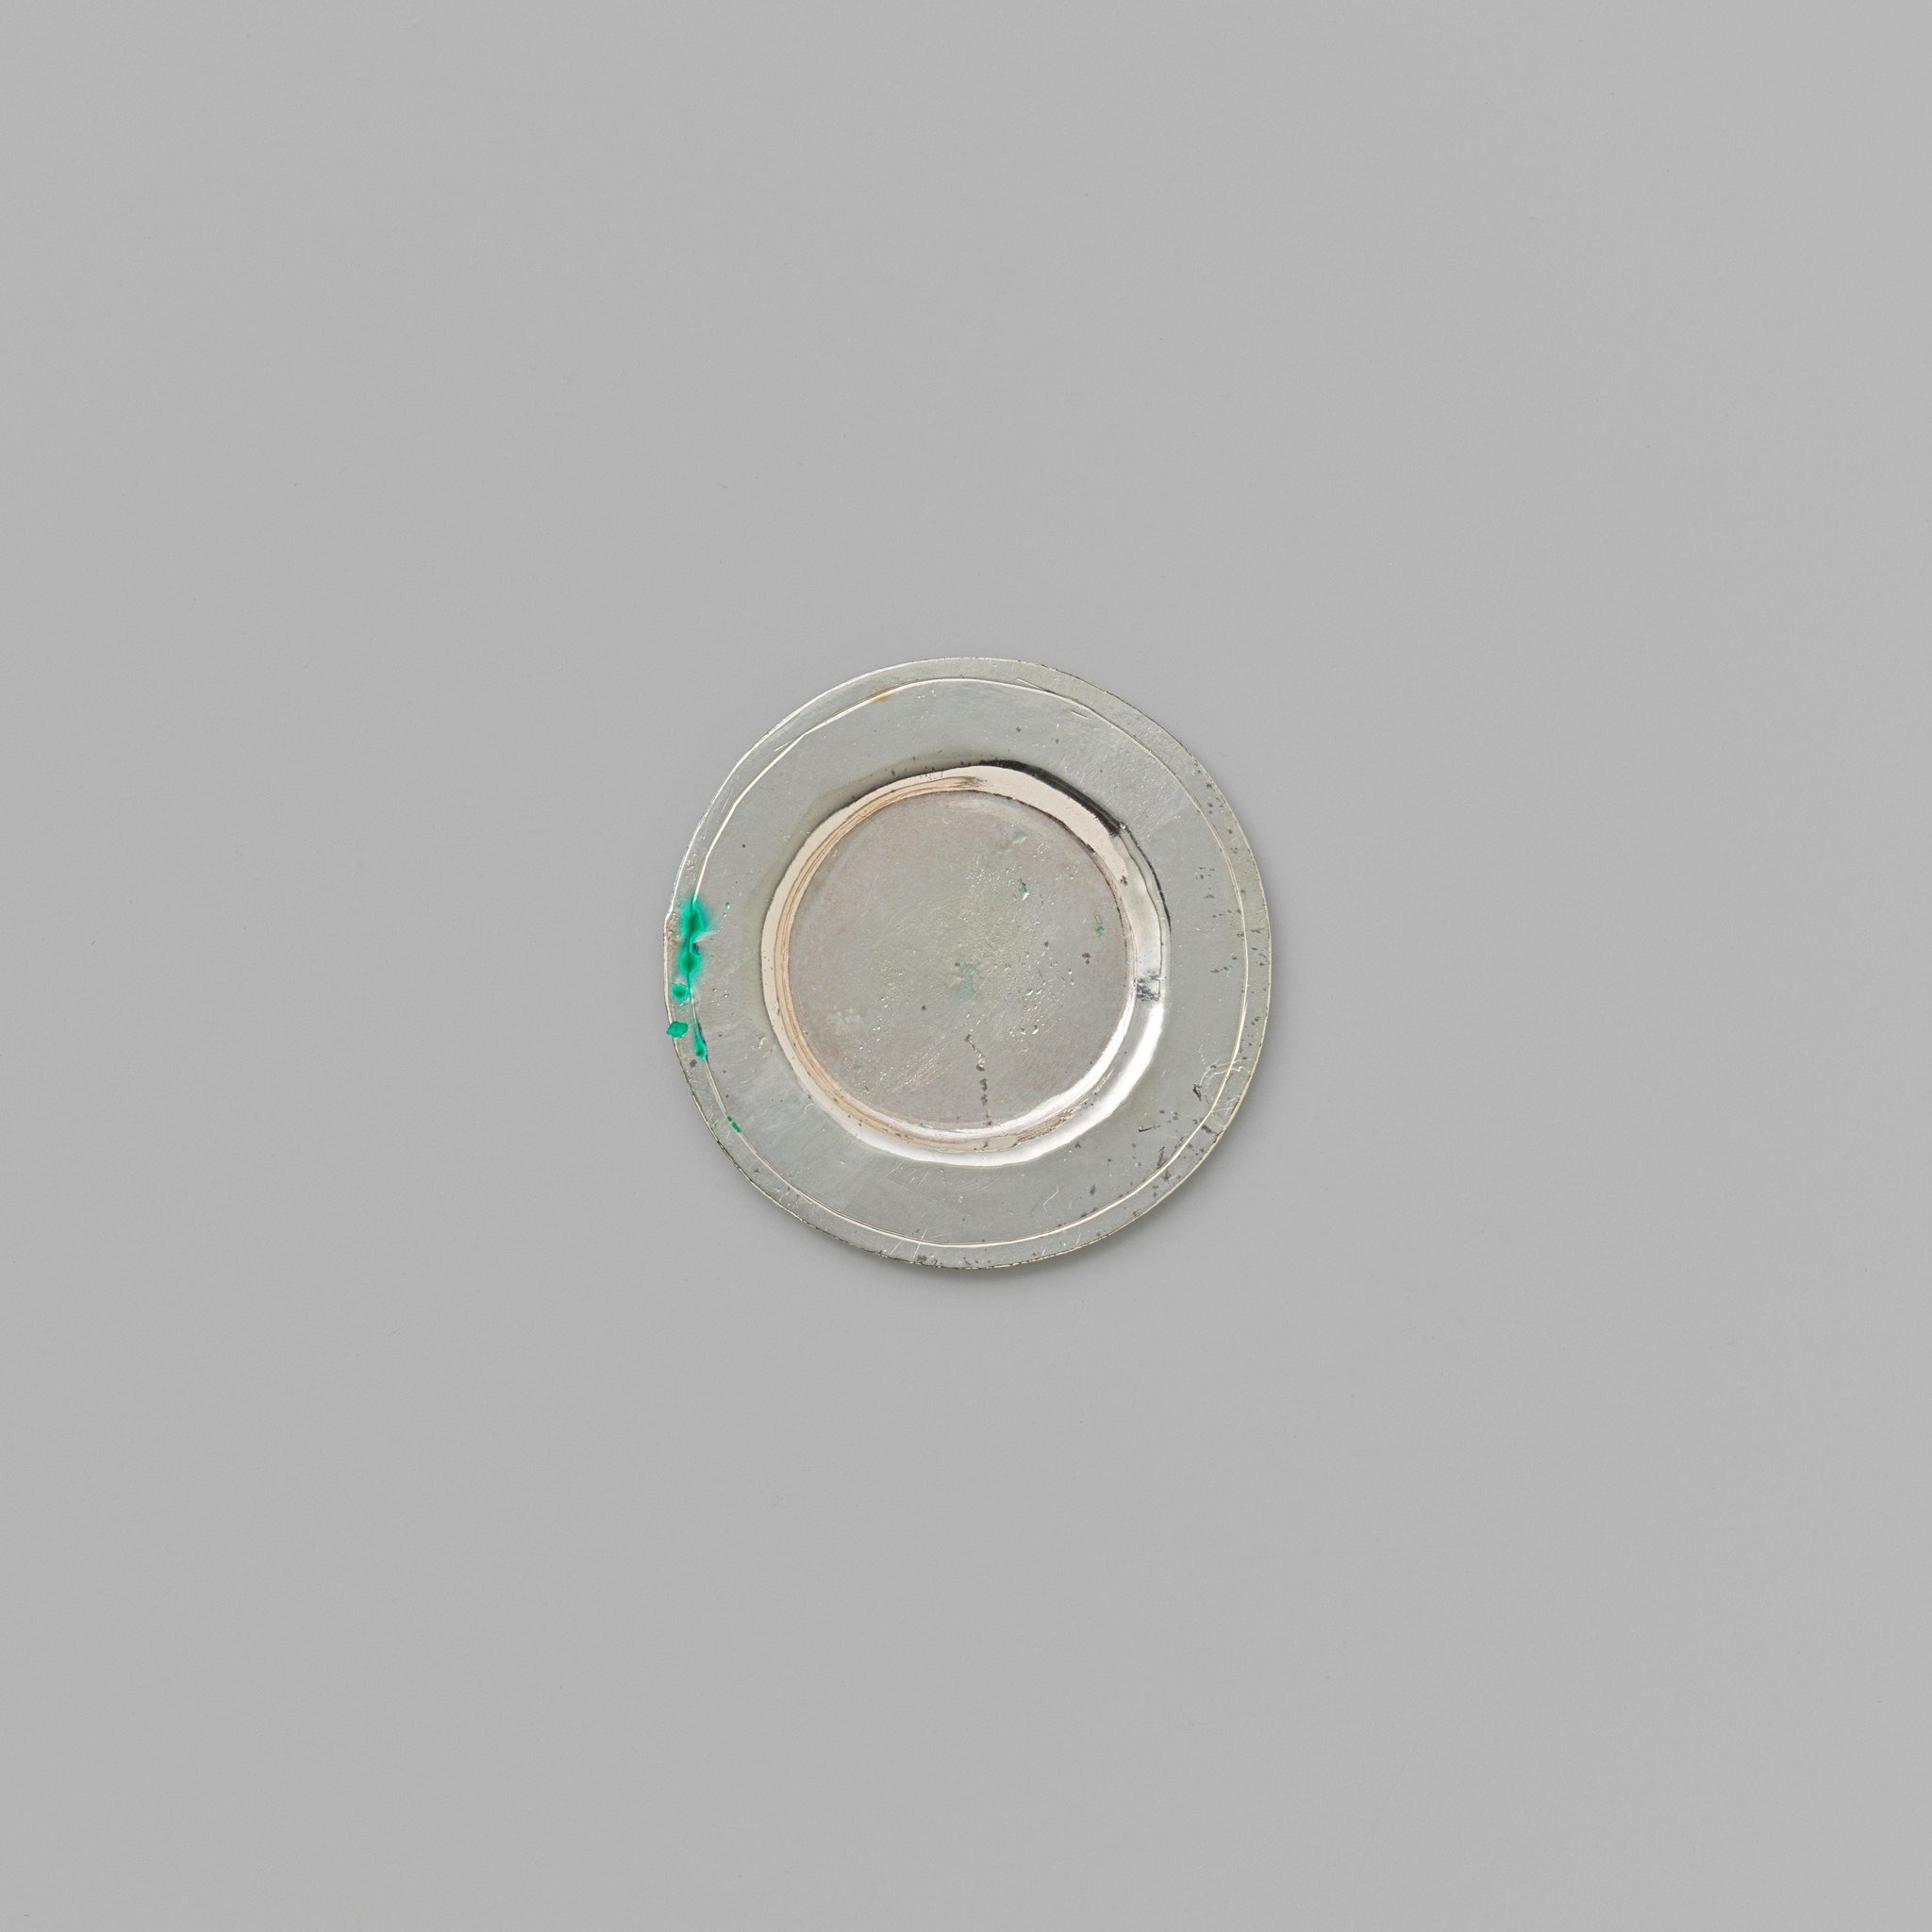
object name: plate dish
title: Bord van zilver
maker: wessel jansen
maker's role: silversmith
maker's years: -1696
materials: silver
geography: amsterdam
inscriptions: maker's mark: ‘W (Citroen 1975, nr. 903)’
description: Bord van zilver, met brede gladde rand met groefversiering